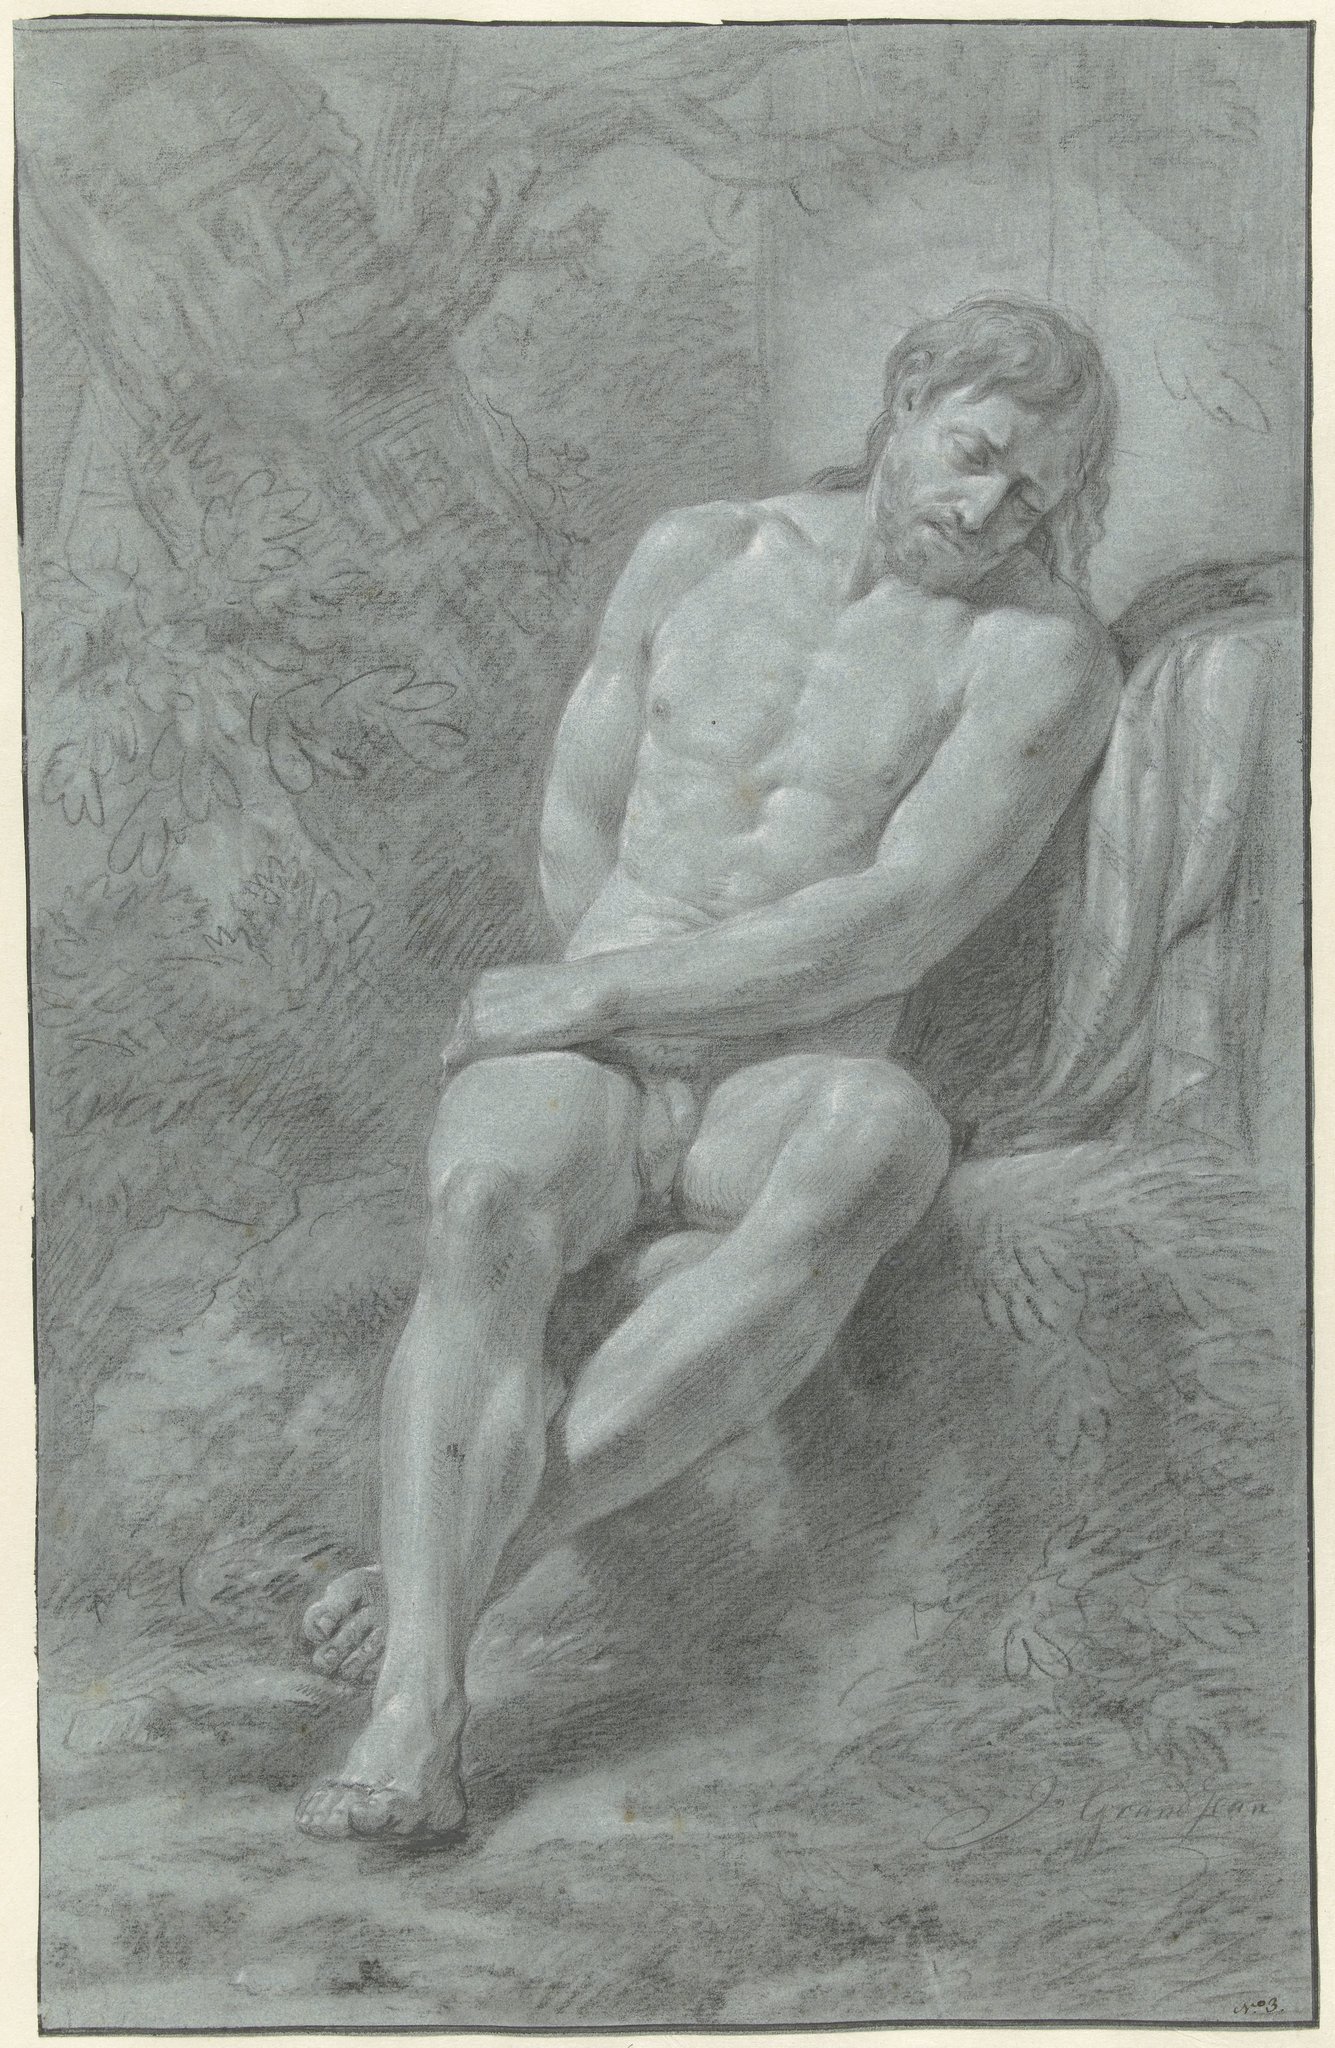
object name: drawing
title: Zittend mannelijk naakt, geleund tegen een steen, van voren gezien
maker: jean grandjean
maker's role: draughtsman, print maker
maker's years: 1752-1781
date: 1765-1781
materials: chalk, paper